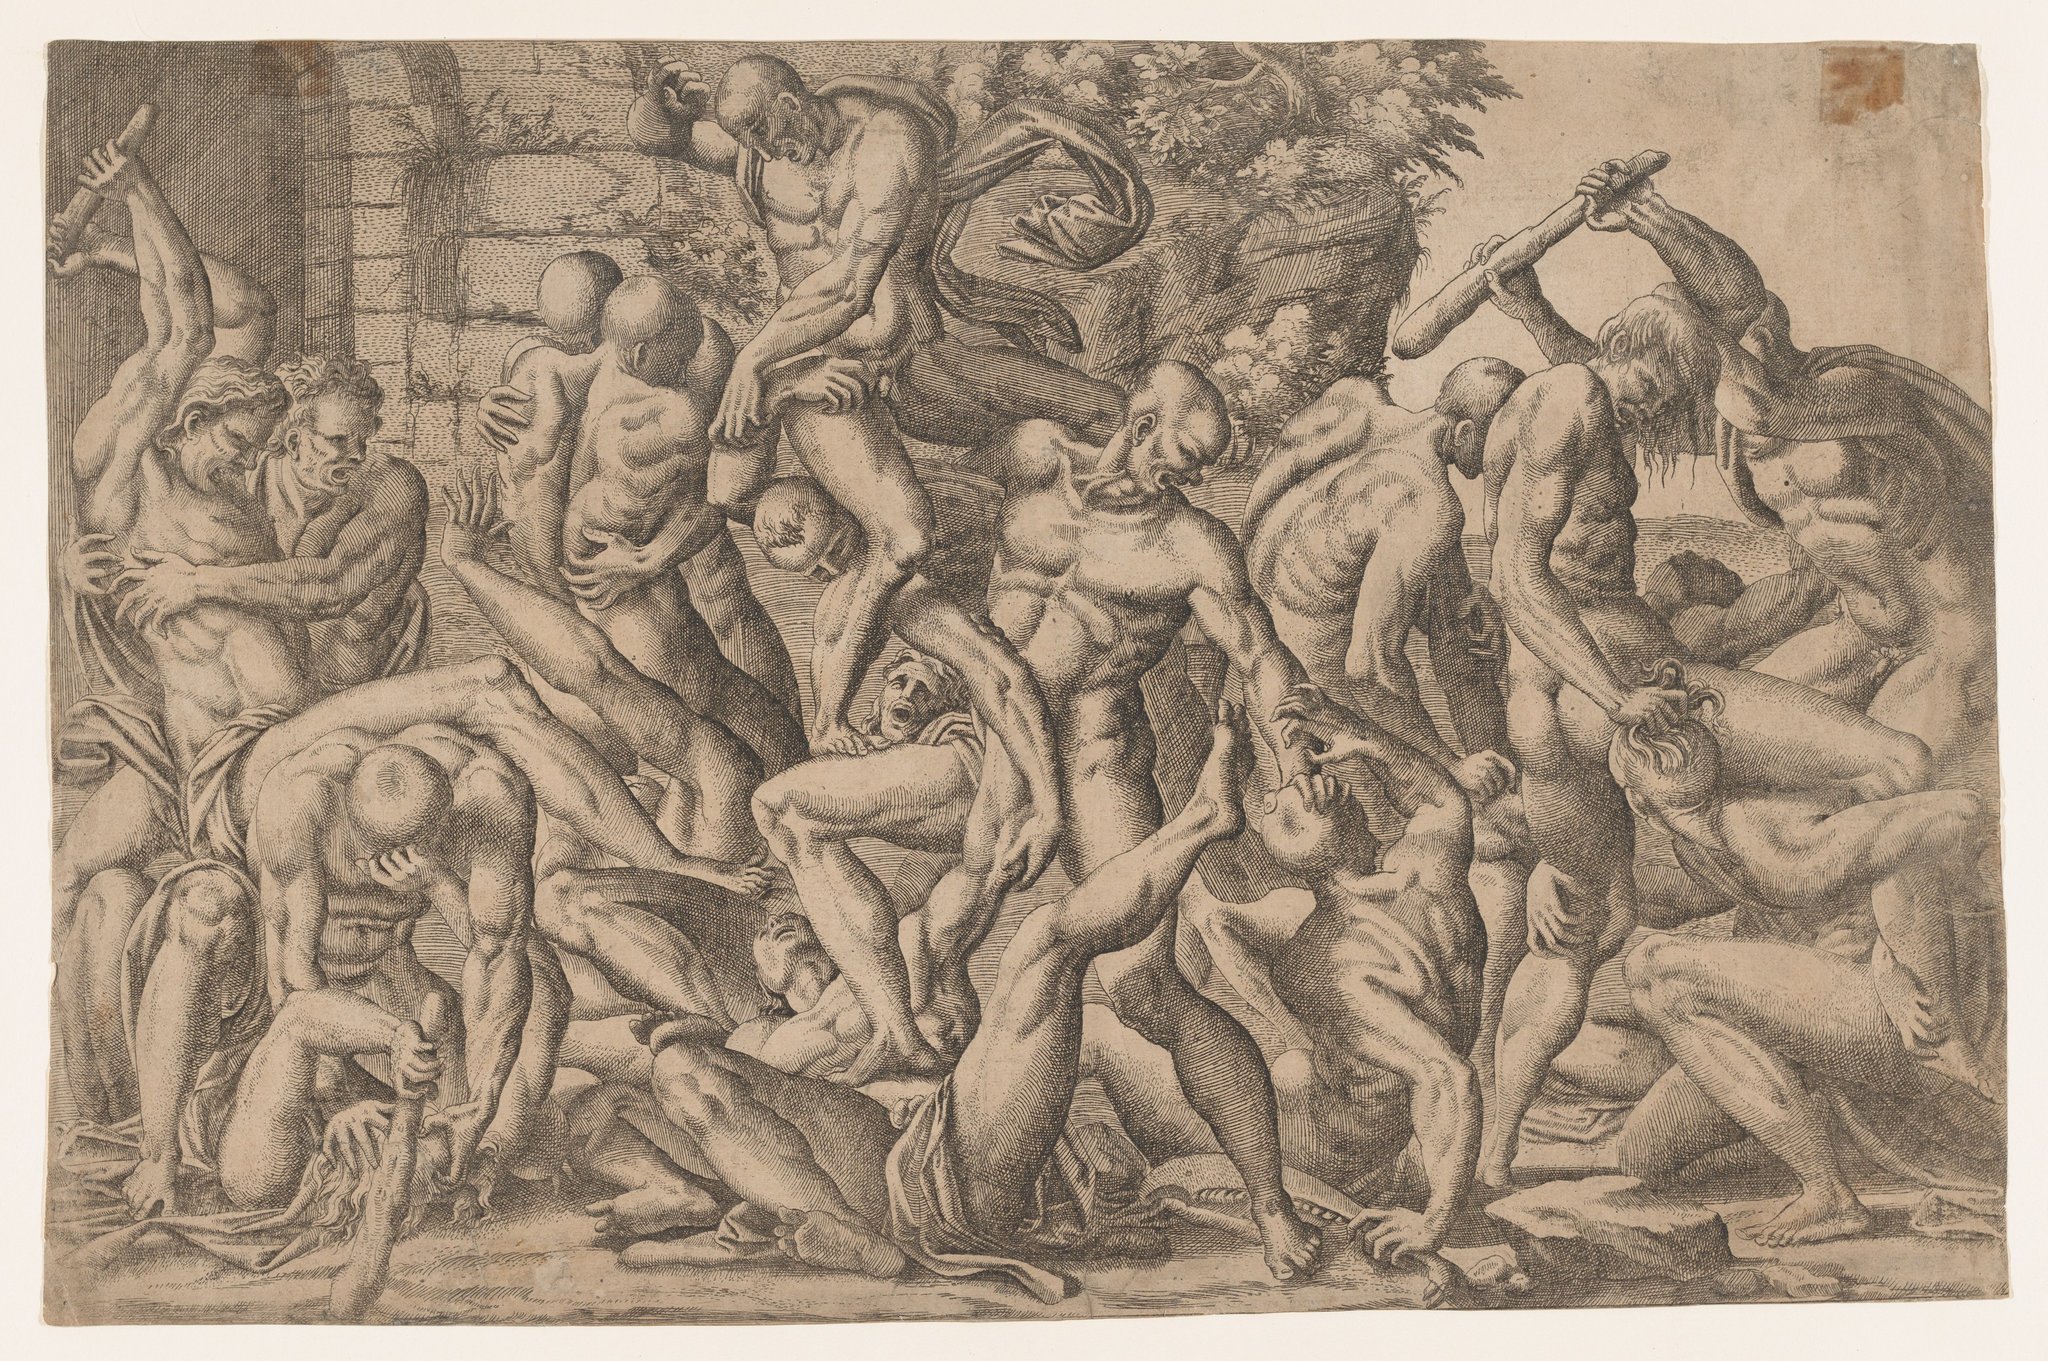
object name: print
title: Combat of Naked Men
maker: jean mignon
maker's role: artist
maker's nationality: french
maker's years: 1535-1555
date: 1535-1555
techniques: etching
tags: battles,male nudes